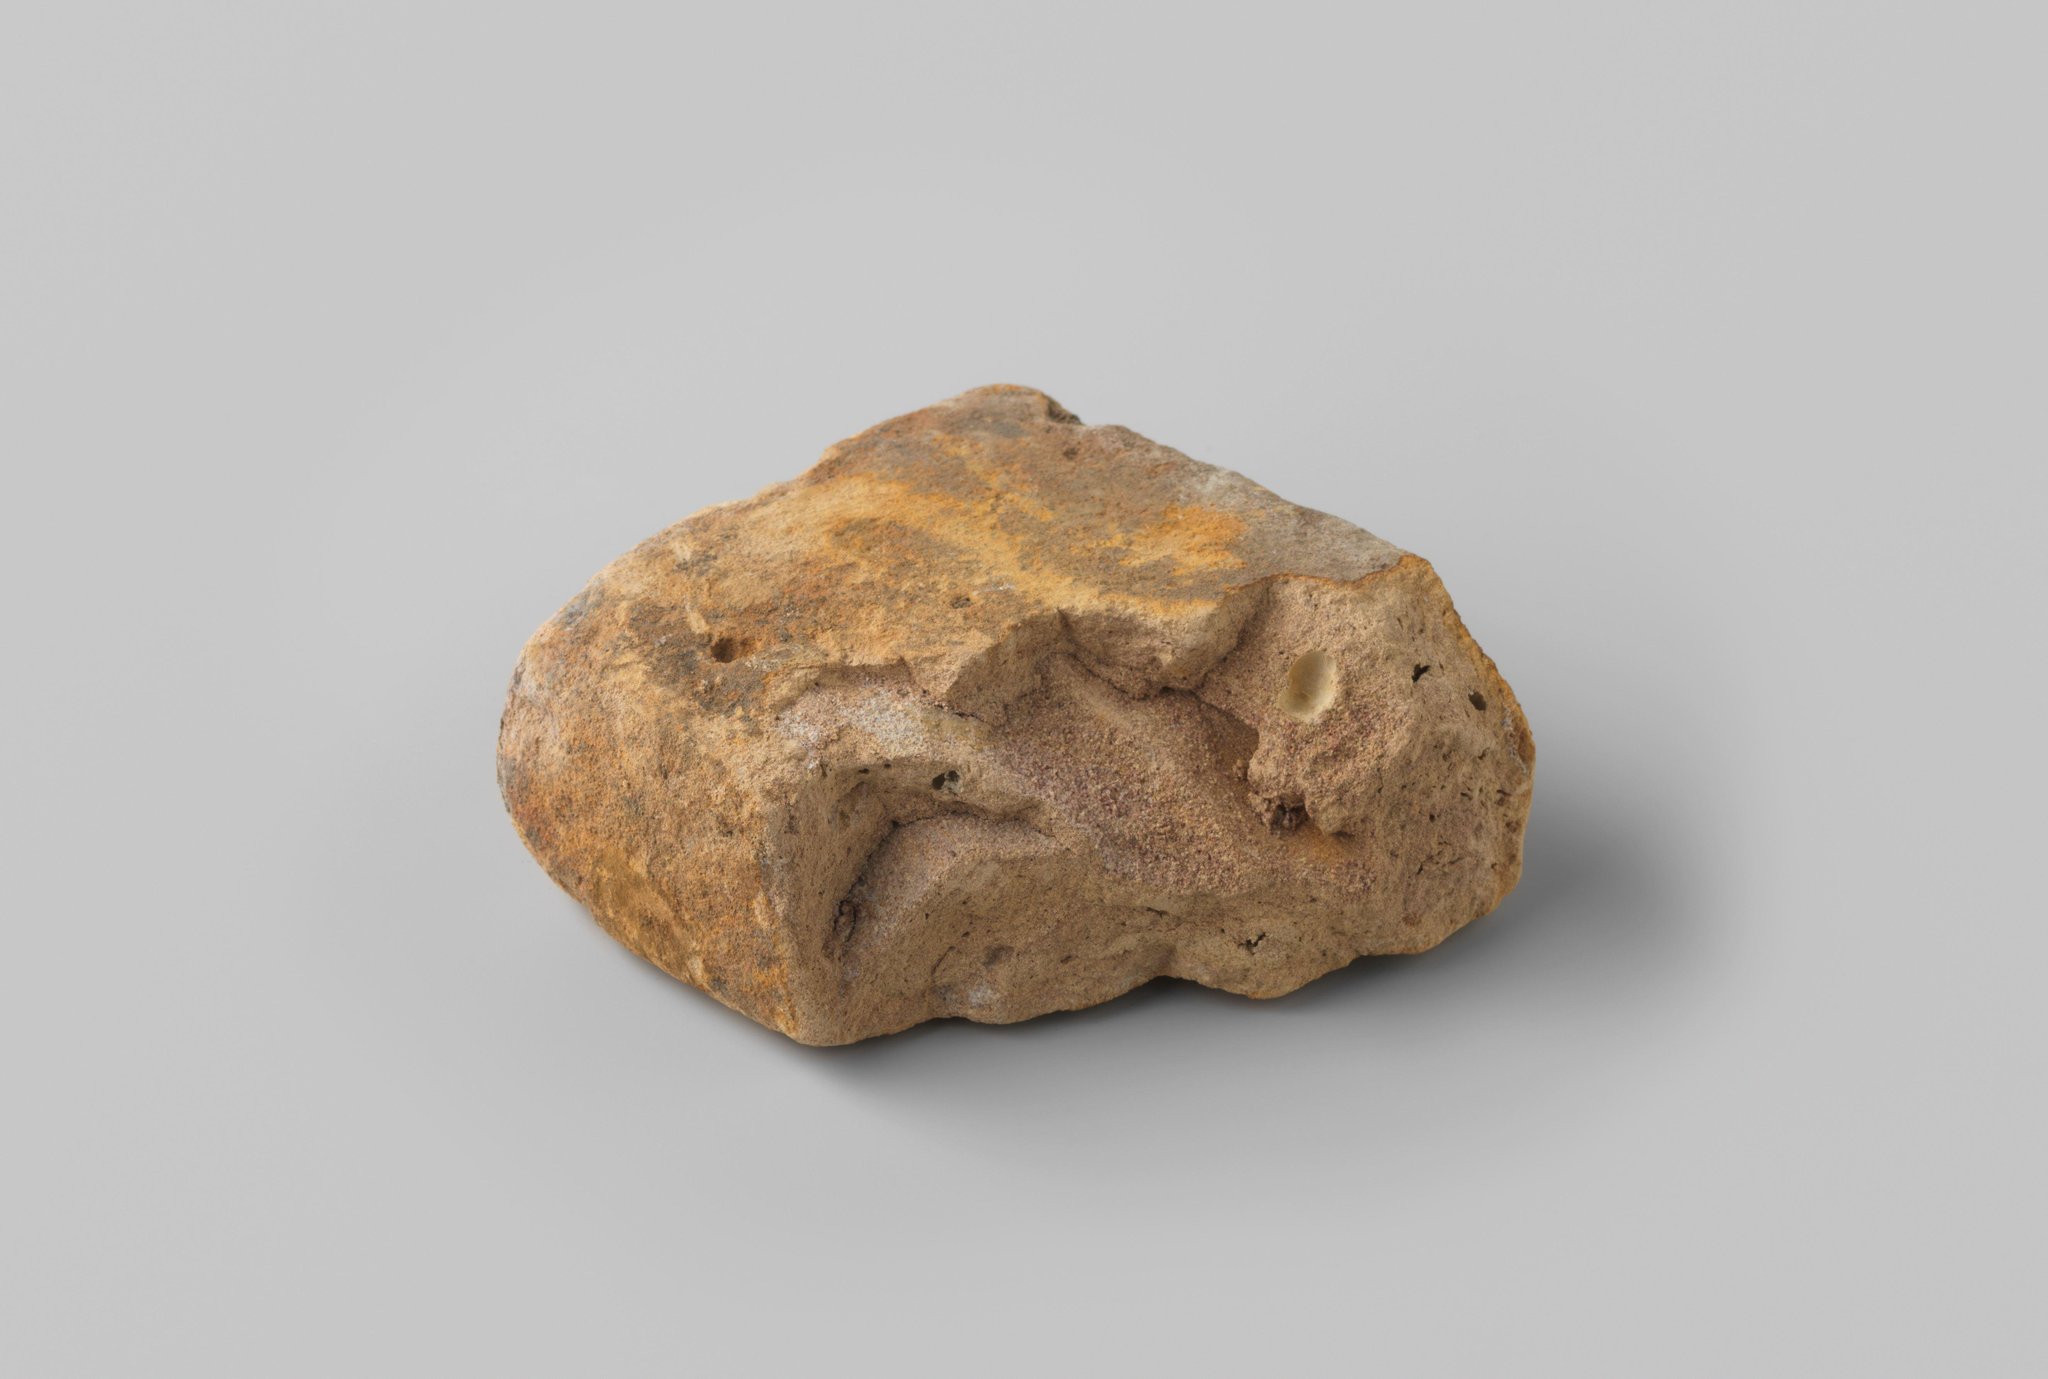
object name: brick clay product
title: Fragment baksteen uit het wrak van de Oost-Indiëvaarder Princesse Maria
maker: Anonymous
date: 1682-1686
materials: brick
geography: netherlands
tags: princesse maria (schip), verenigde oostindische compagnie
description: Ca 20 hele en stukken van gele bakstenen, enkele door metselwerk verbonden. De bakstenen zijn veelal donker verkleurd (beroet) hetgeen erop wijst dat ze deel hebben uitgemaakt van de kombuis. En 80 hele en gebroken gele IJsselstenen of tichelstenen. Brick.